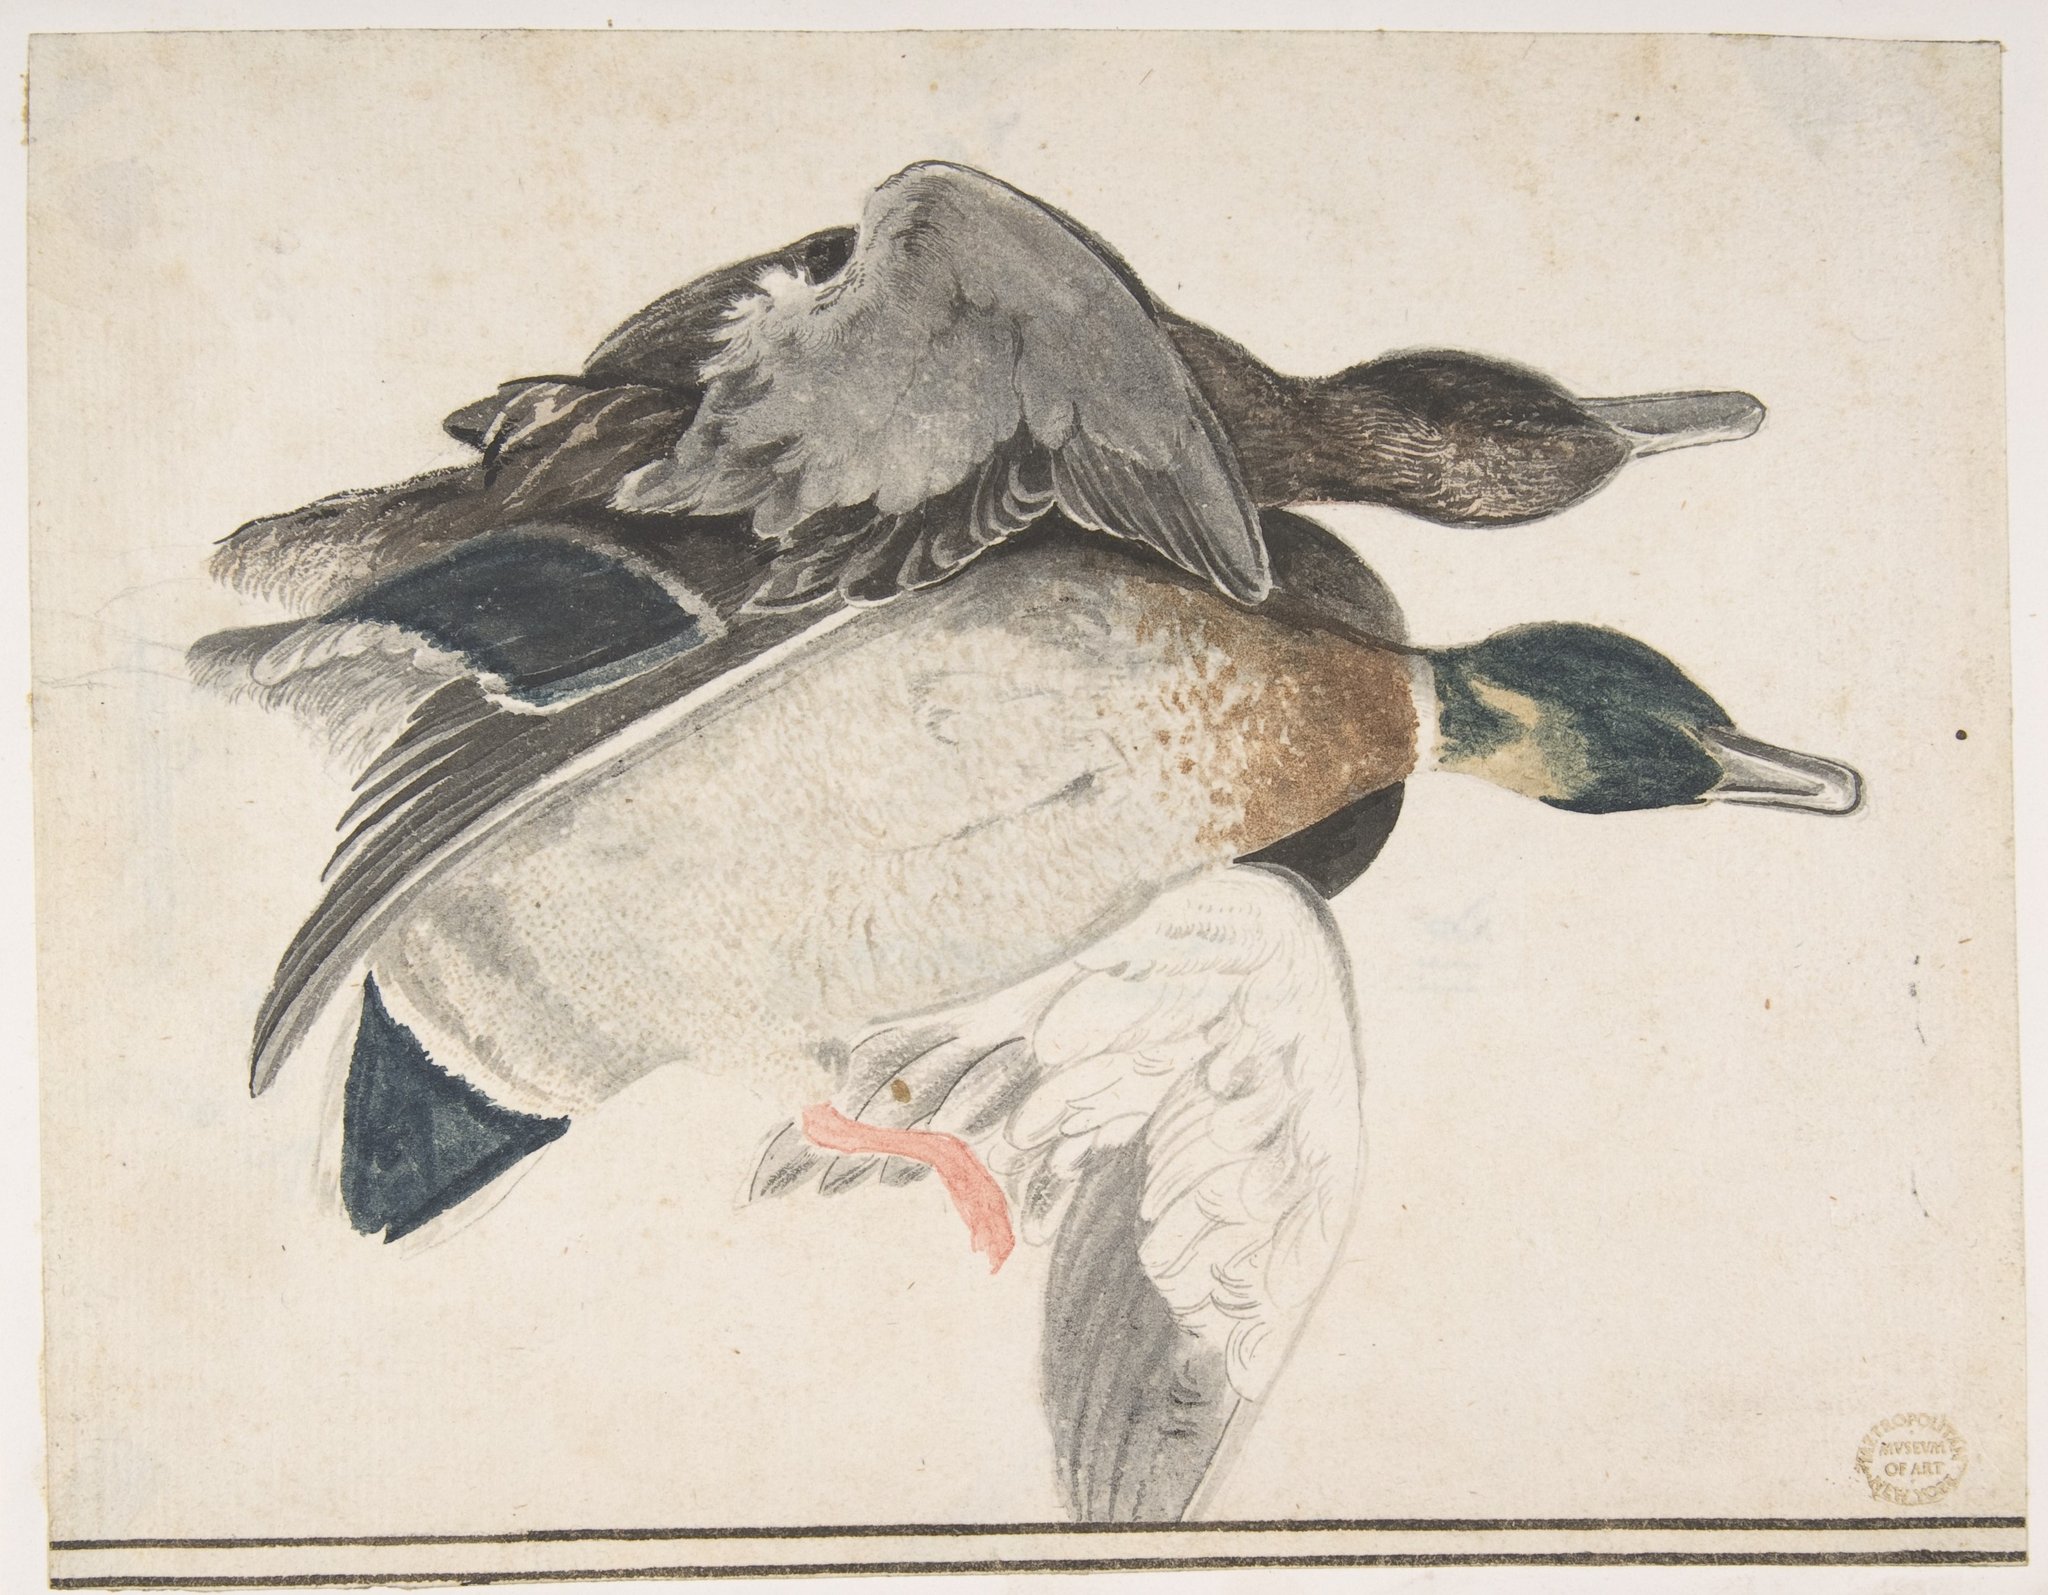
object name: drawing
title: Two Dead Ducks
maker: count giorgio durante (duranti)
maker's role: artist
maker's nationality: italian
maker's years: 1685-1755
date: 1705-1755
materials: ink, drawing material, watercolor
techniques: pen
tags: ducks